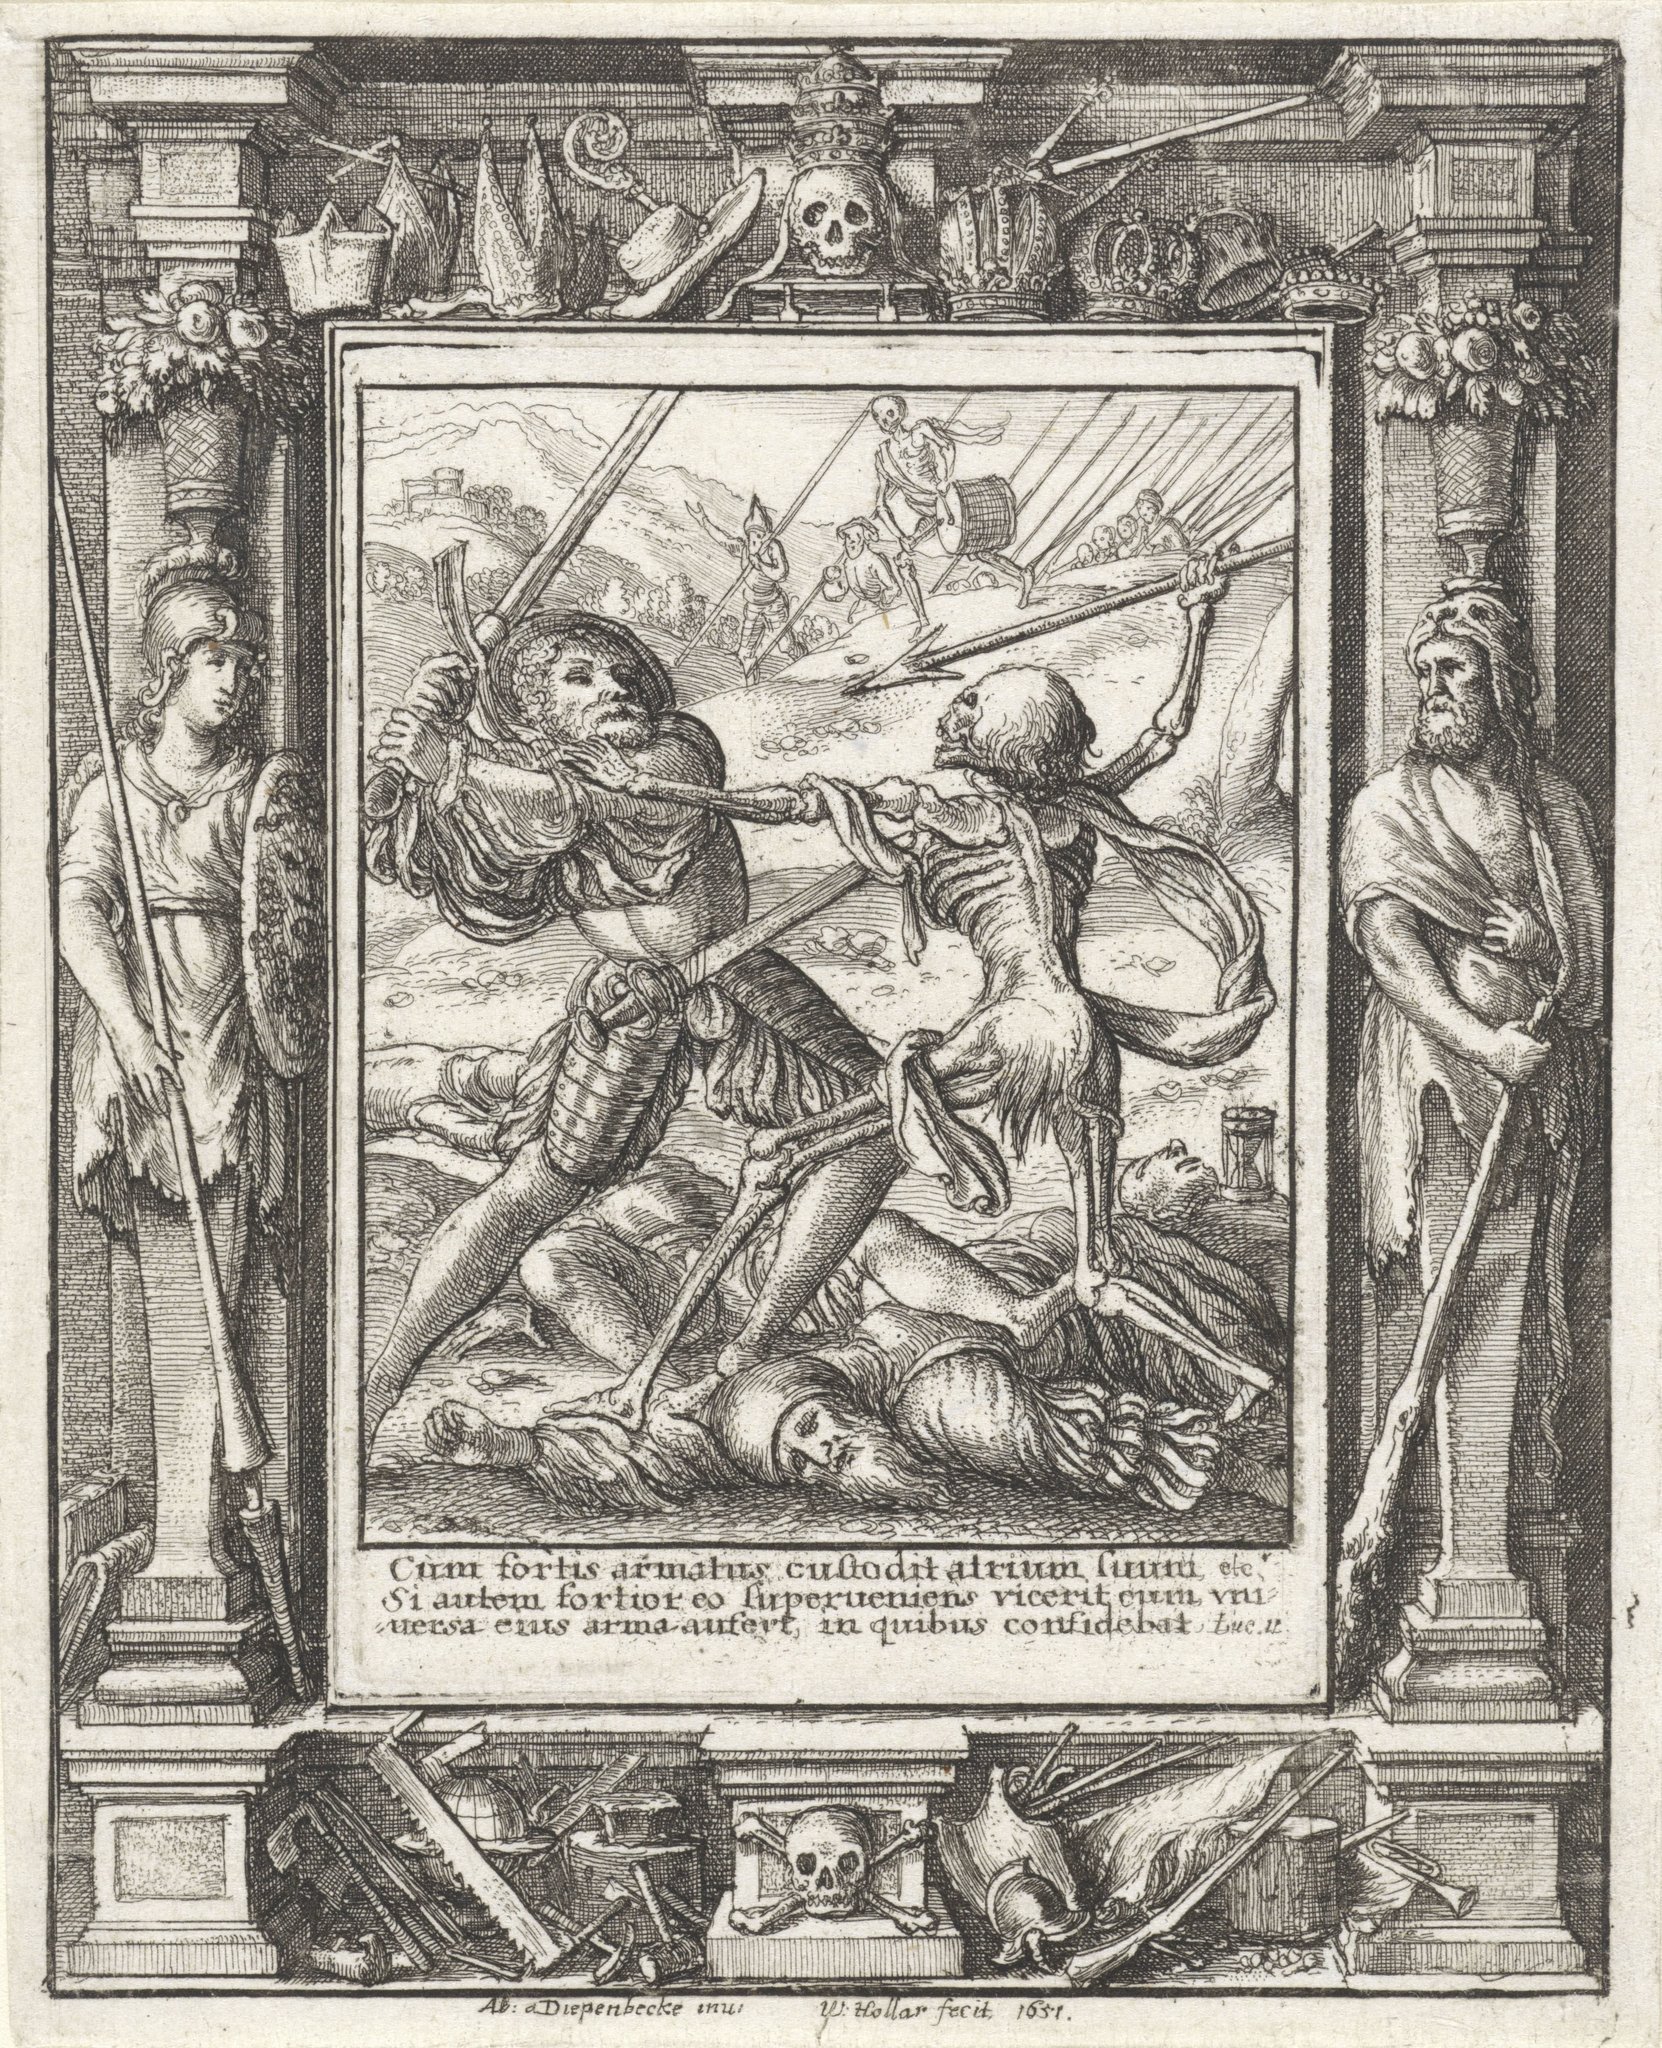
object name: print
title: Dodendans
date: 1651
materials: paper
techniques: etching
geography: antwerp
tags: (story of) hercules (heracles), (story of) minerva (pallas, athena), death battling with life, or with the living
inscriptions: collector's mark: Lugt 2228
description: Een ridder in gevecht met de Dood. Negentiende prent uit een reeks van 30 dodendansprenten; met een omlijsting met Minerva en Hercules.